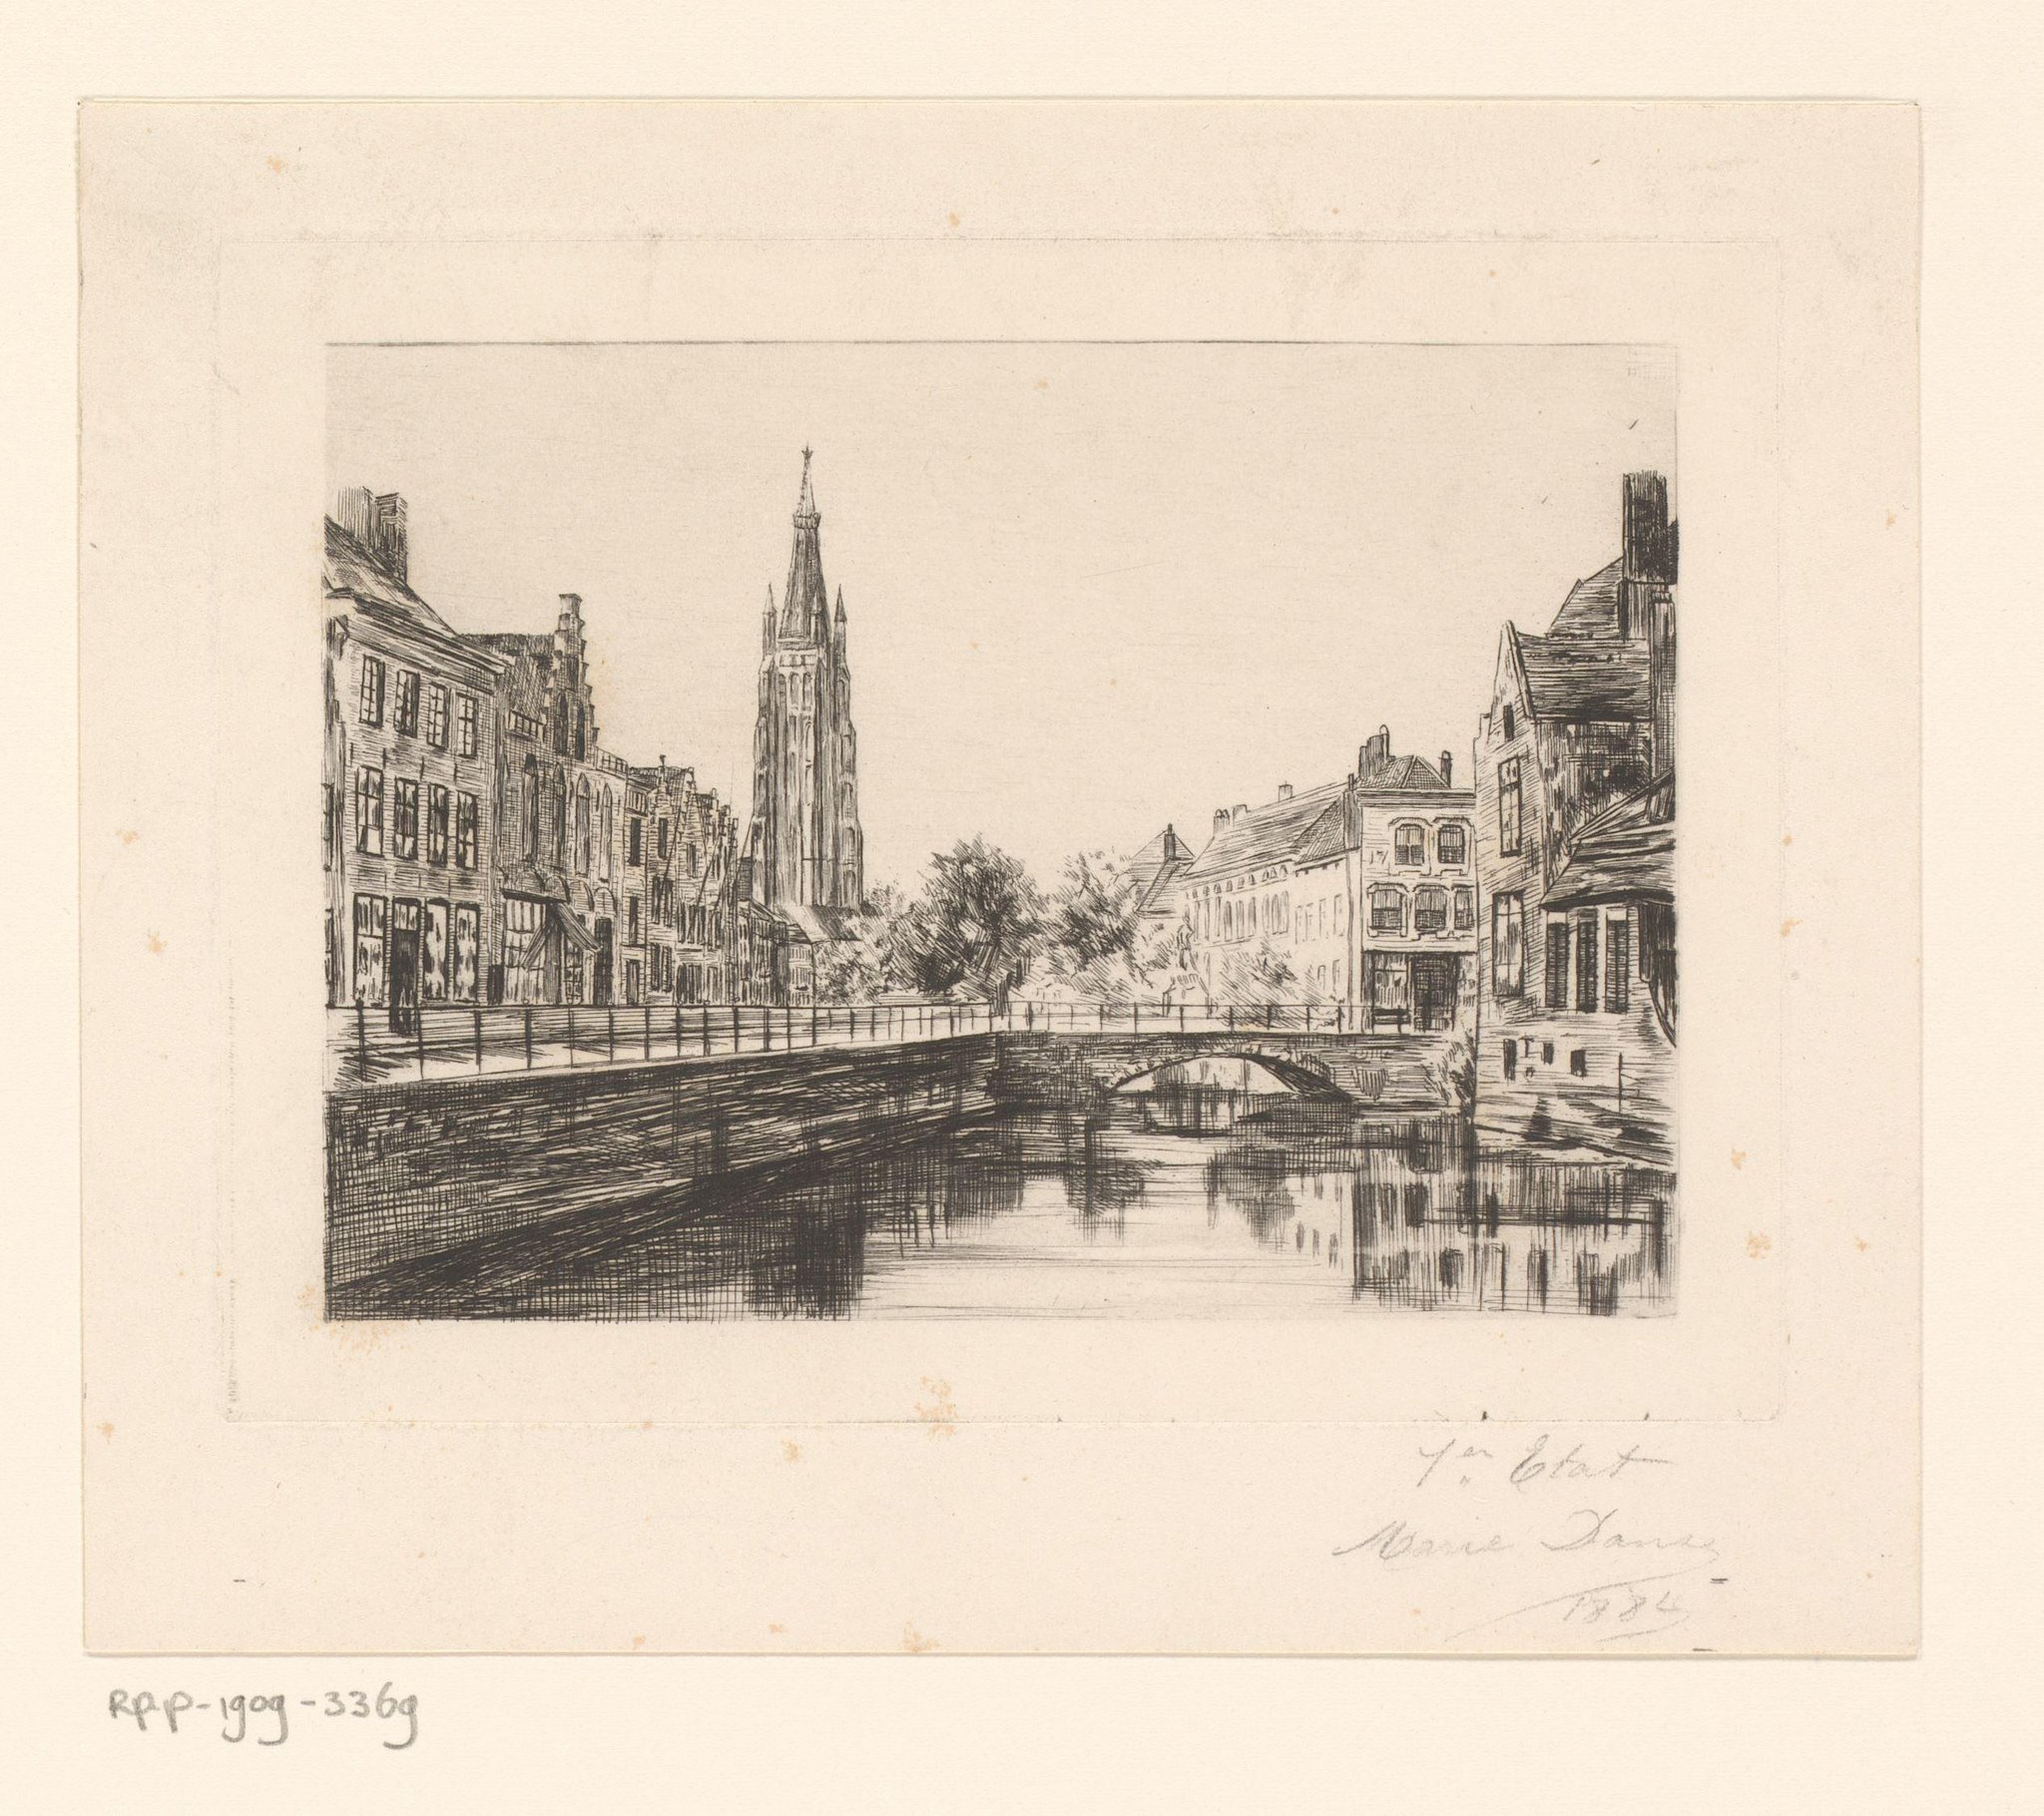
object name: print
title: Brug van Sint-Jean Nepomucène te Brugge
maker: marie danse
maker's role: print maker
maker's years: 1867-1942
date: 1884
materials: paper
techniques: etching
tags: bridge in city across river, canal, etc., bruges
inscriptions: inscription: ‘1m Etat’, collector's mark: Lugt 2228